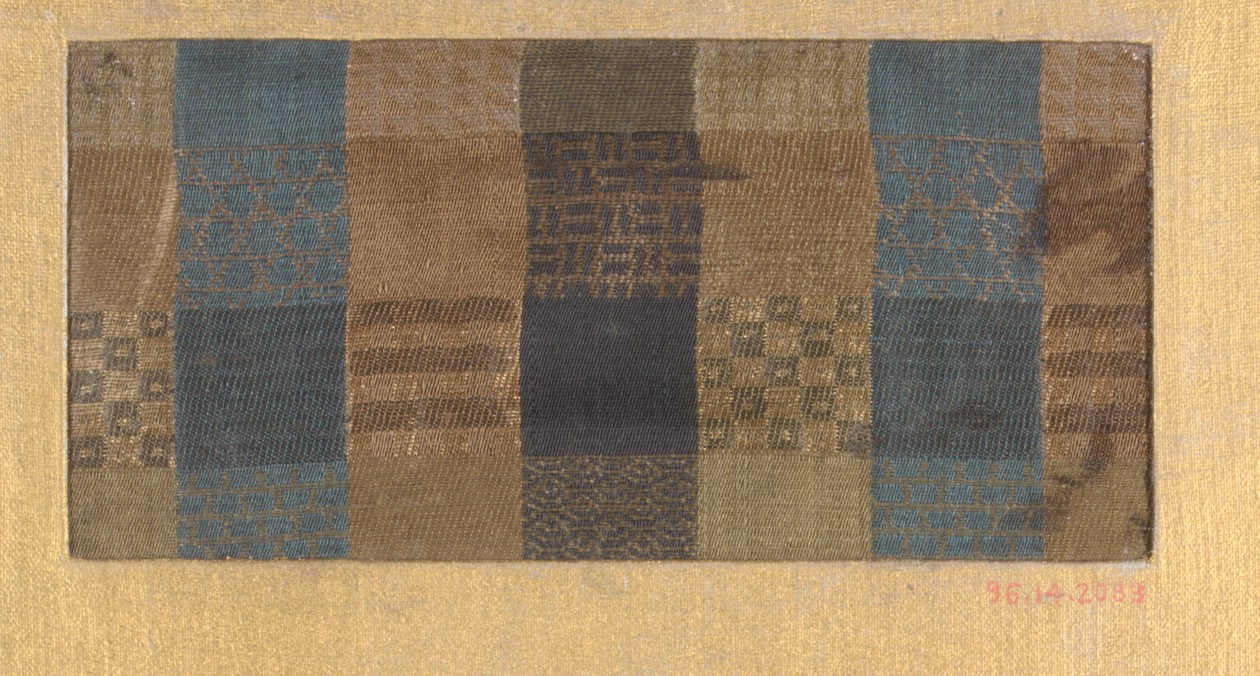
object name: piece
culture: japanese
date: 1701-1900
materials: silk